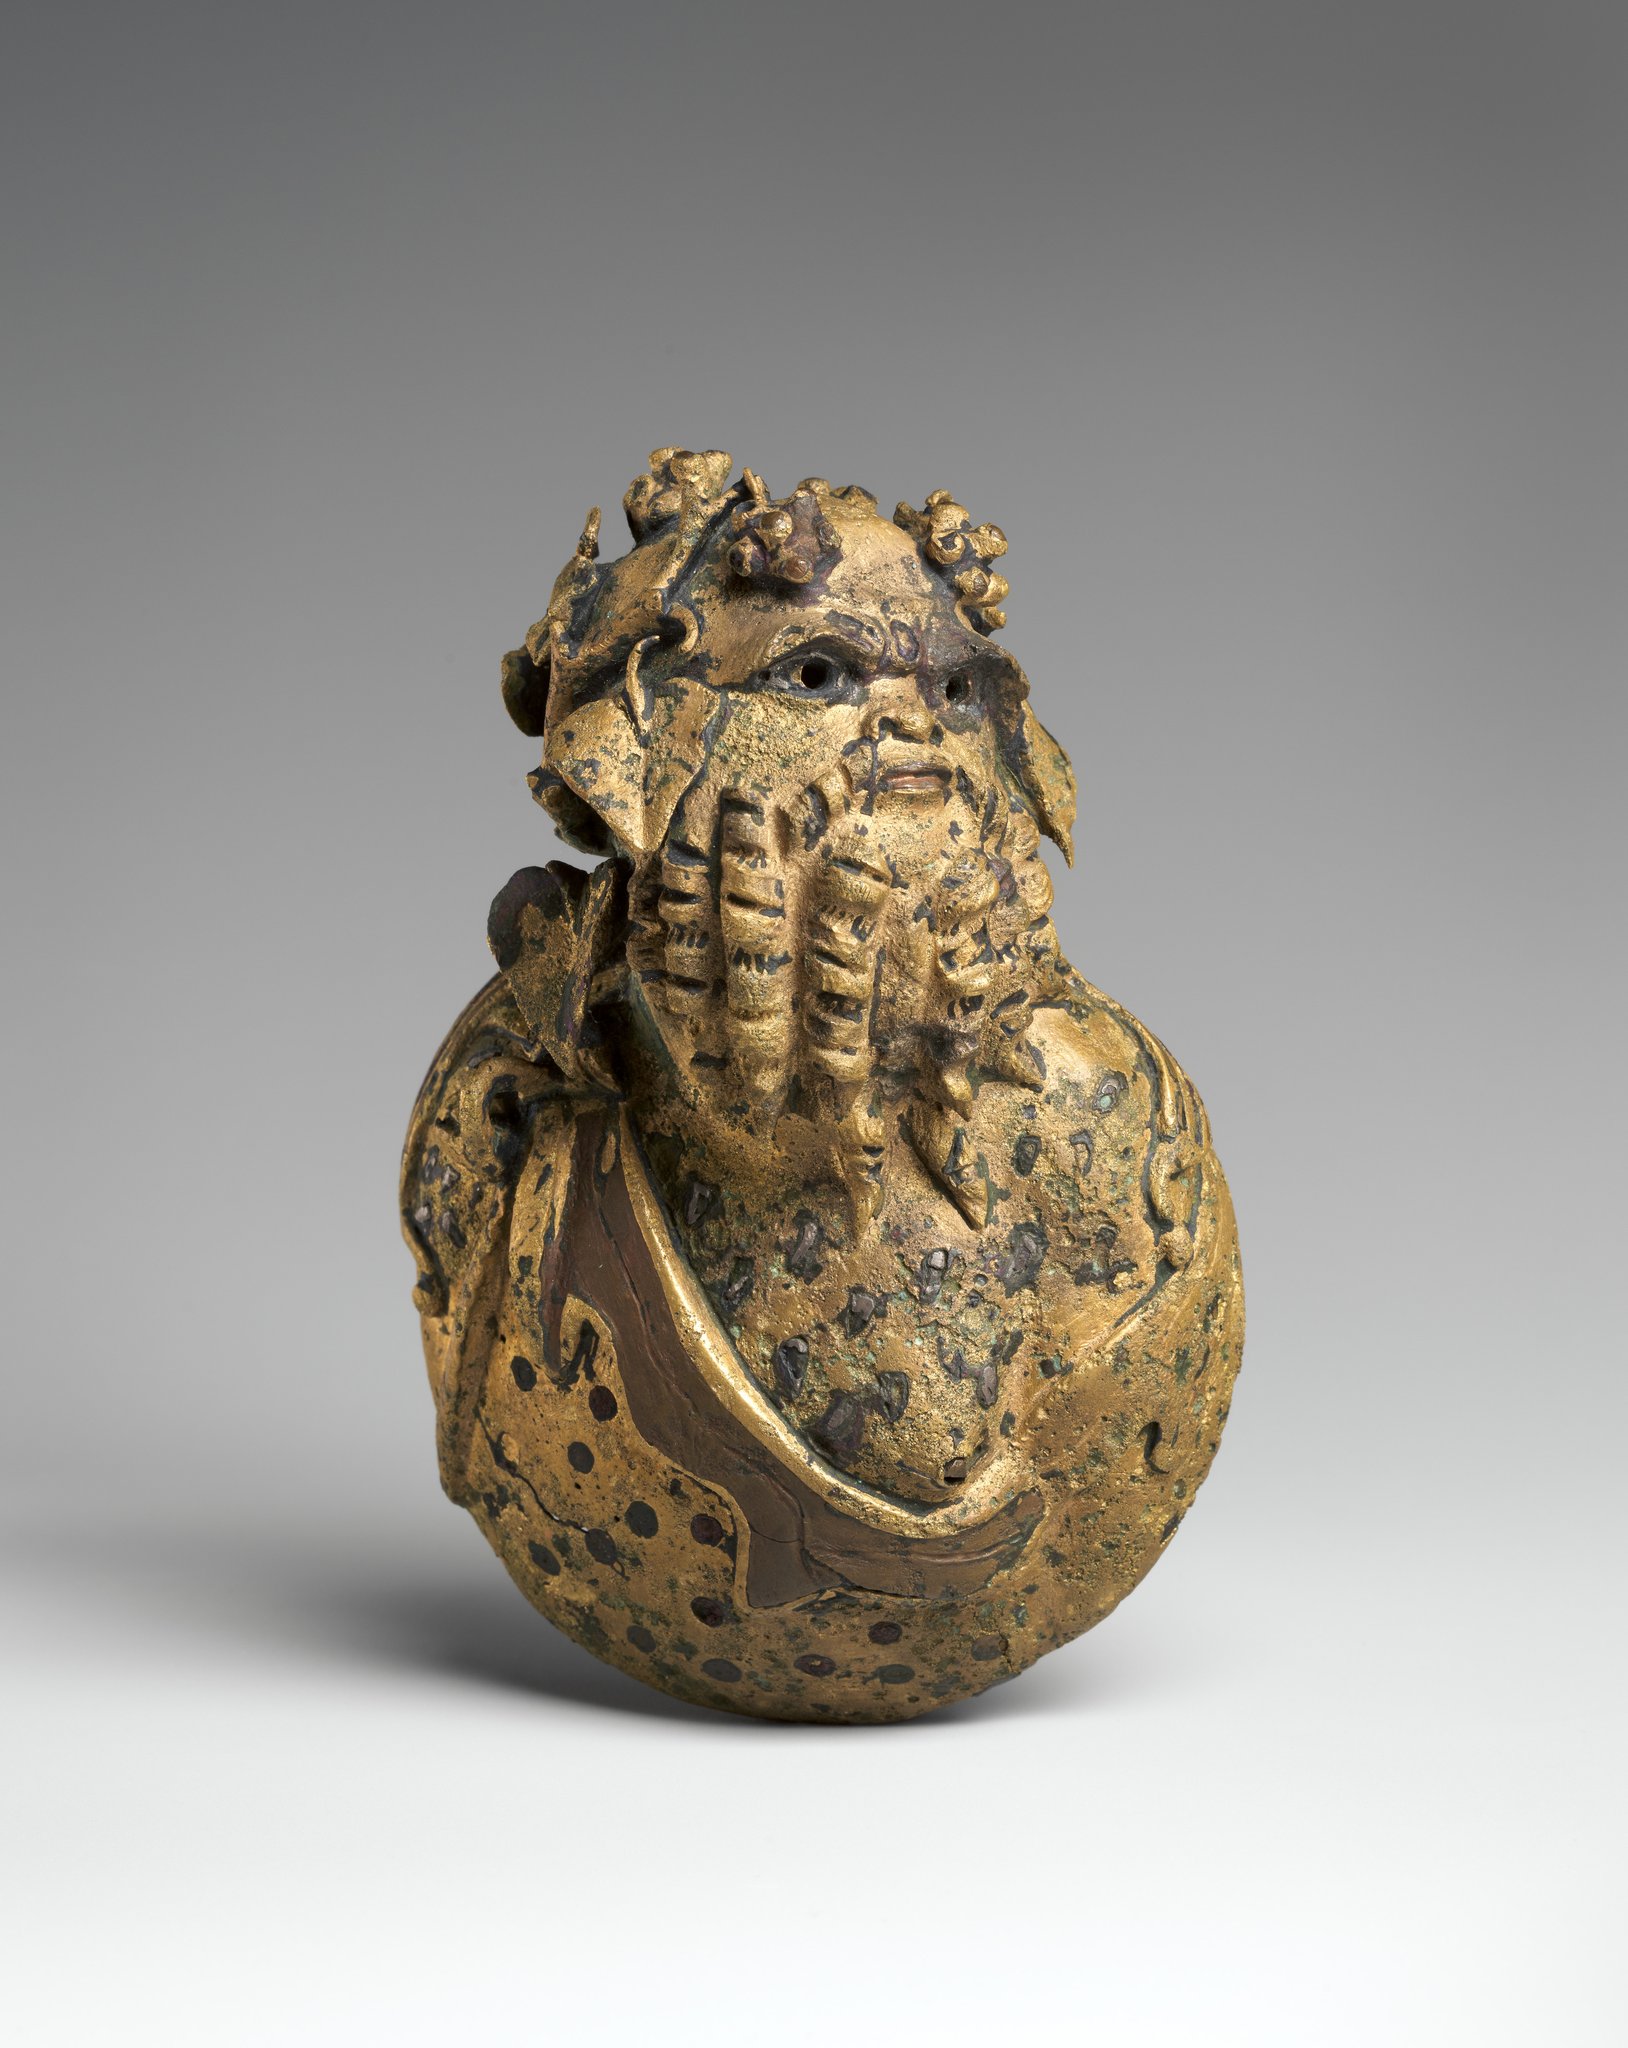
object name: couch attachment in the form of a silenus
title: Bronze bust of a Silenus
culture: roman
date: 50-125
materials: bronze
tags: silenus